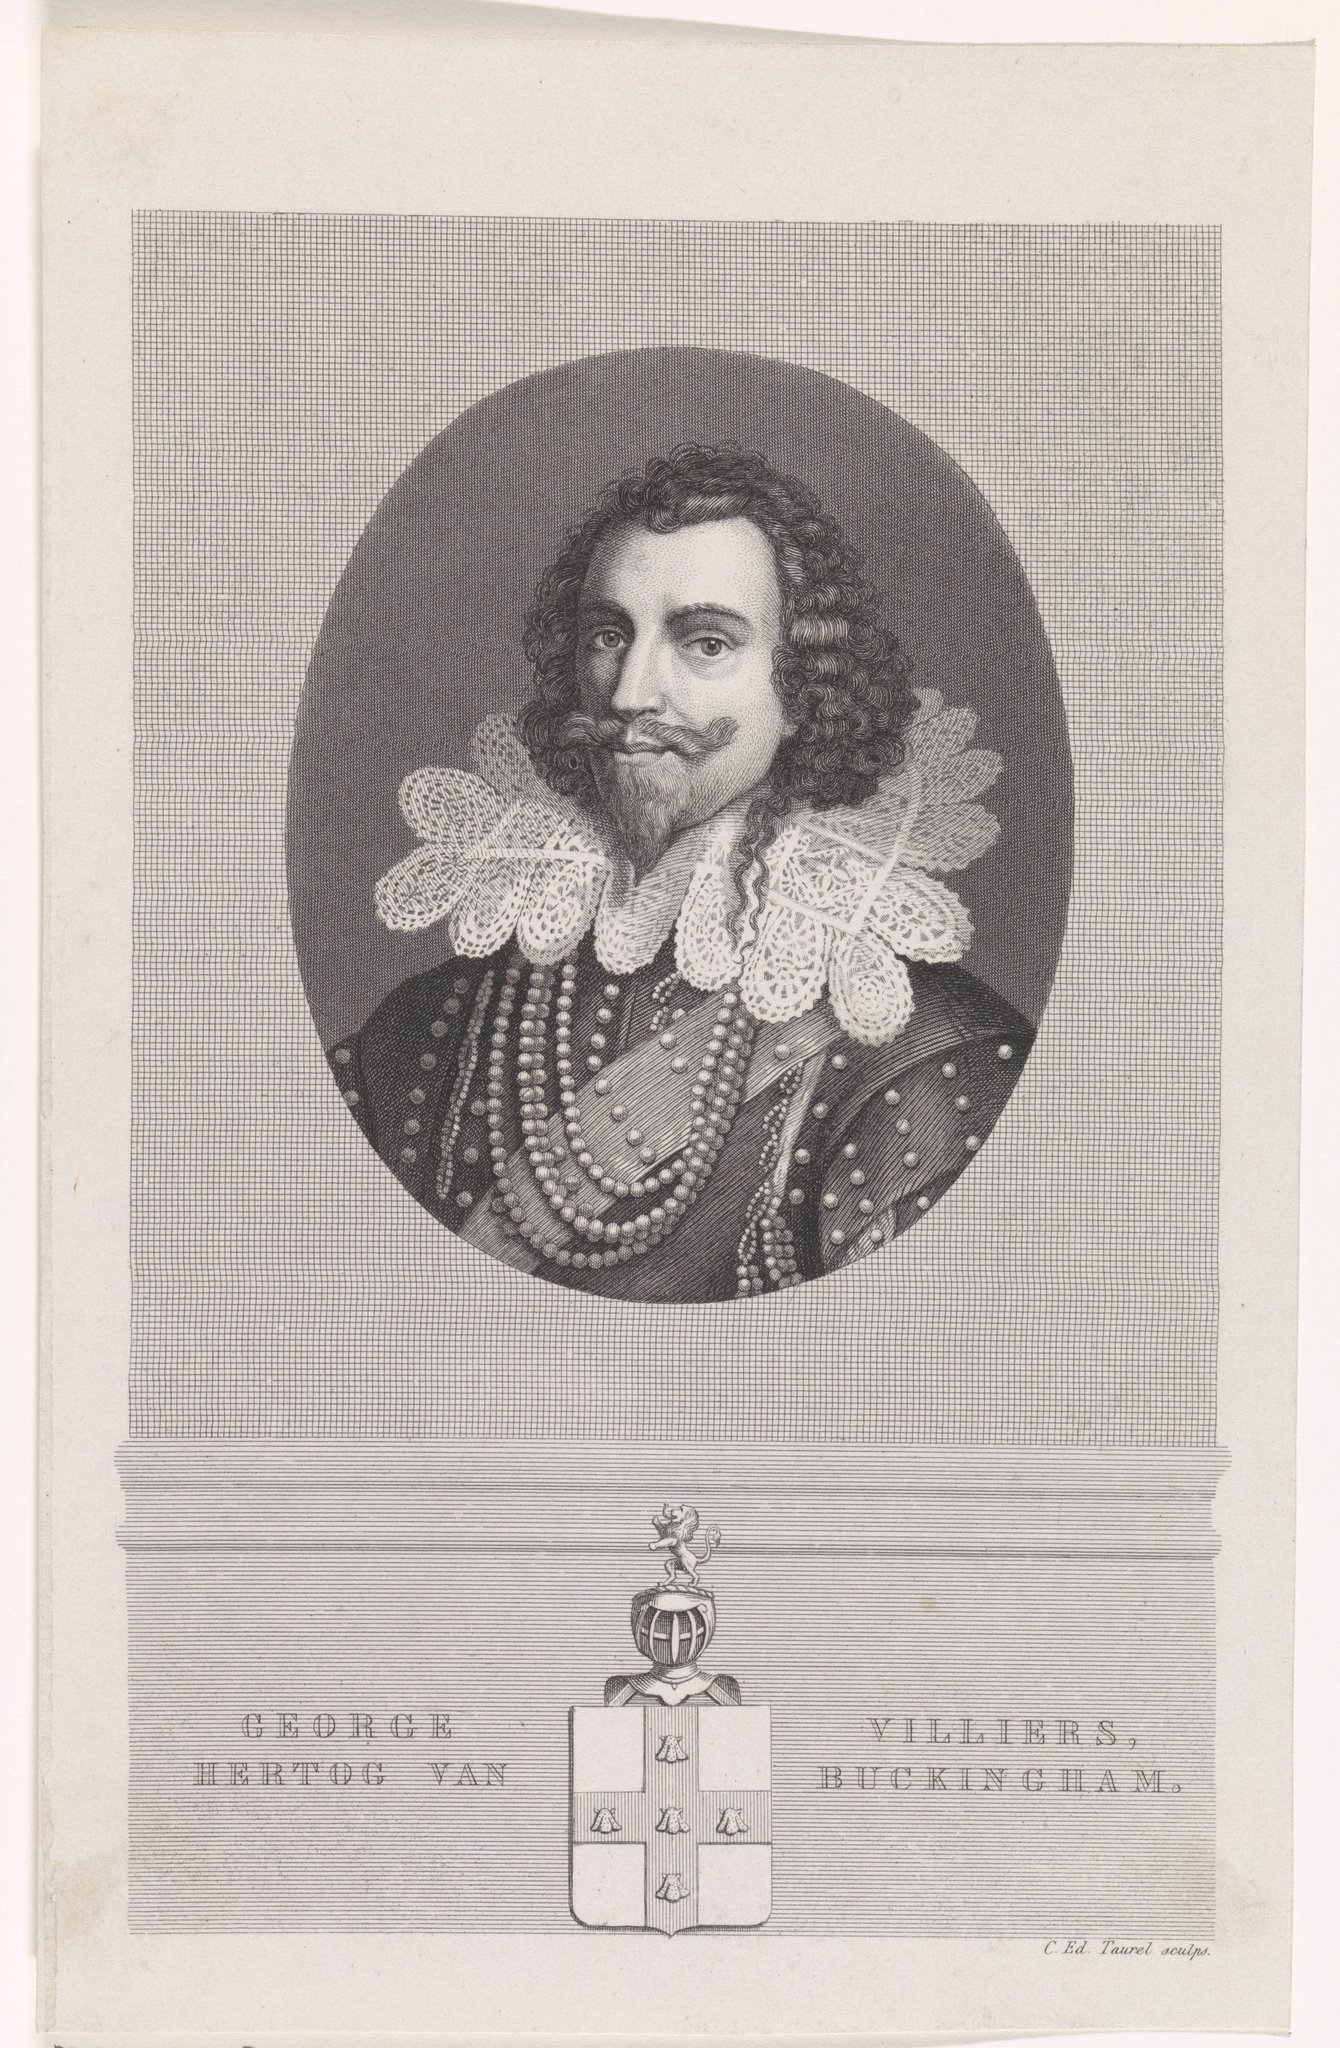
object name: print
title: Portret van George Villiers, 1e hertog van Buckingham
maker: edouard taurel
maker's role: draughtsman, print maker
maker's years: 1824-1892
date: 1841-1879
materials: paper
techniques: engraving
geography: amsterdam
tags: hertog, george villiers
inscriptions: collector's mark: Lugt 2228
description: Prent ook gebruikt als illustratie voor: Arend, Johannes Pieter. Algemeene geschiedenis des vaderlands van de vroegste tijden tot op heden. 5 delen. Amsterdam: J.F. Schleijer, 1841-1884. dl. III.4, p. 331.